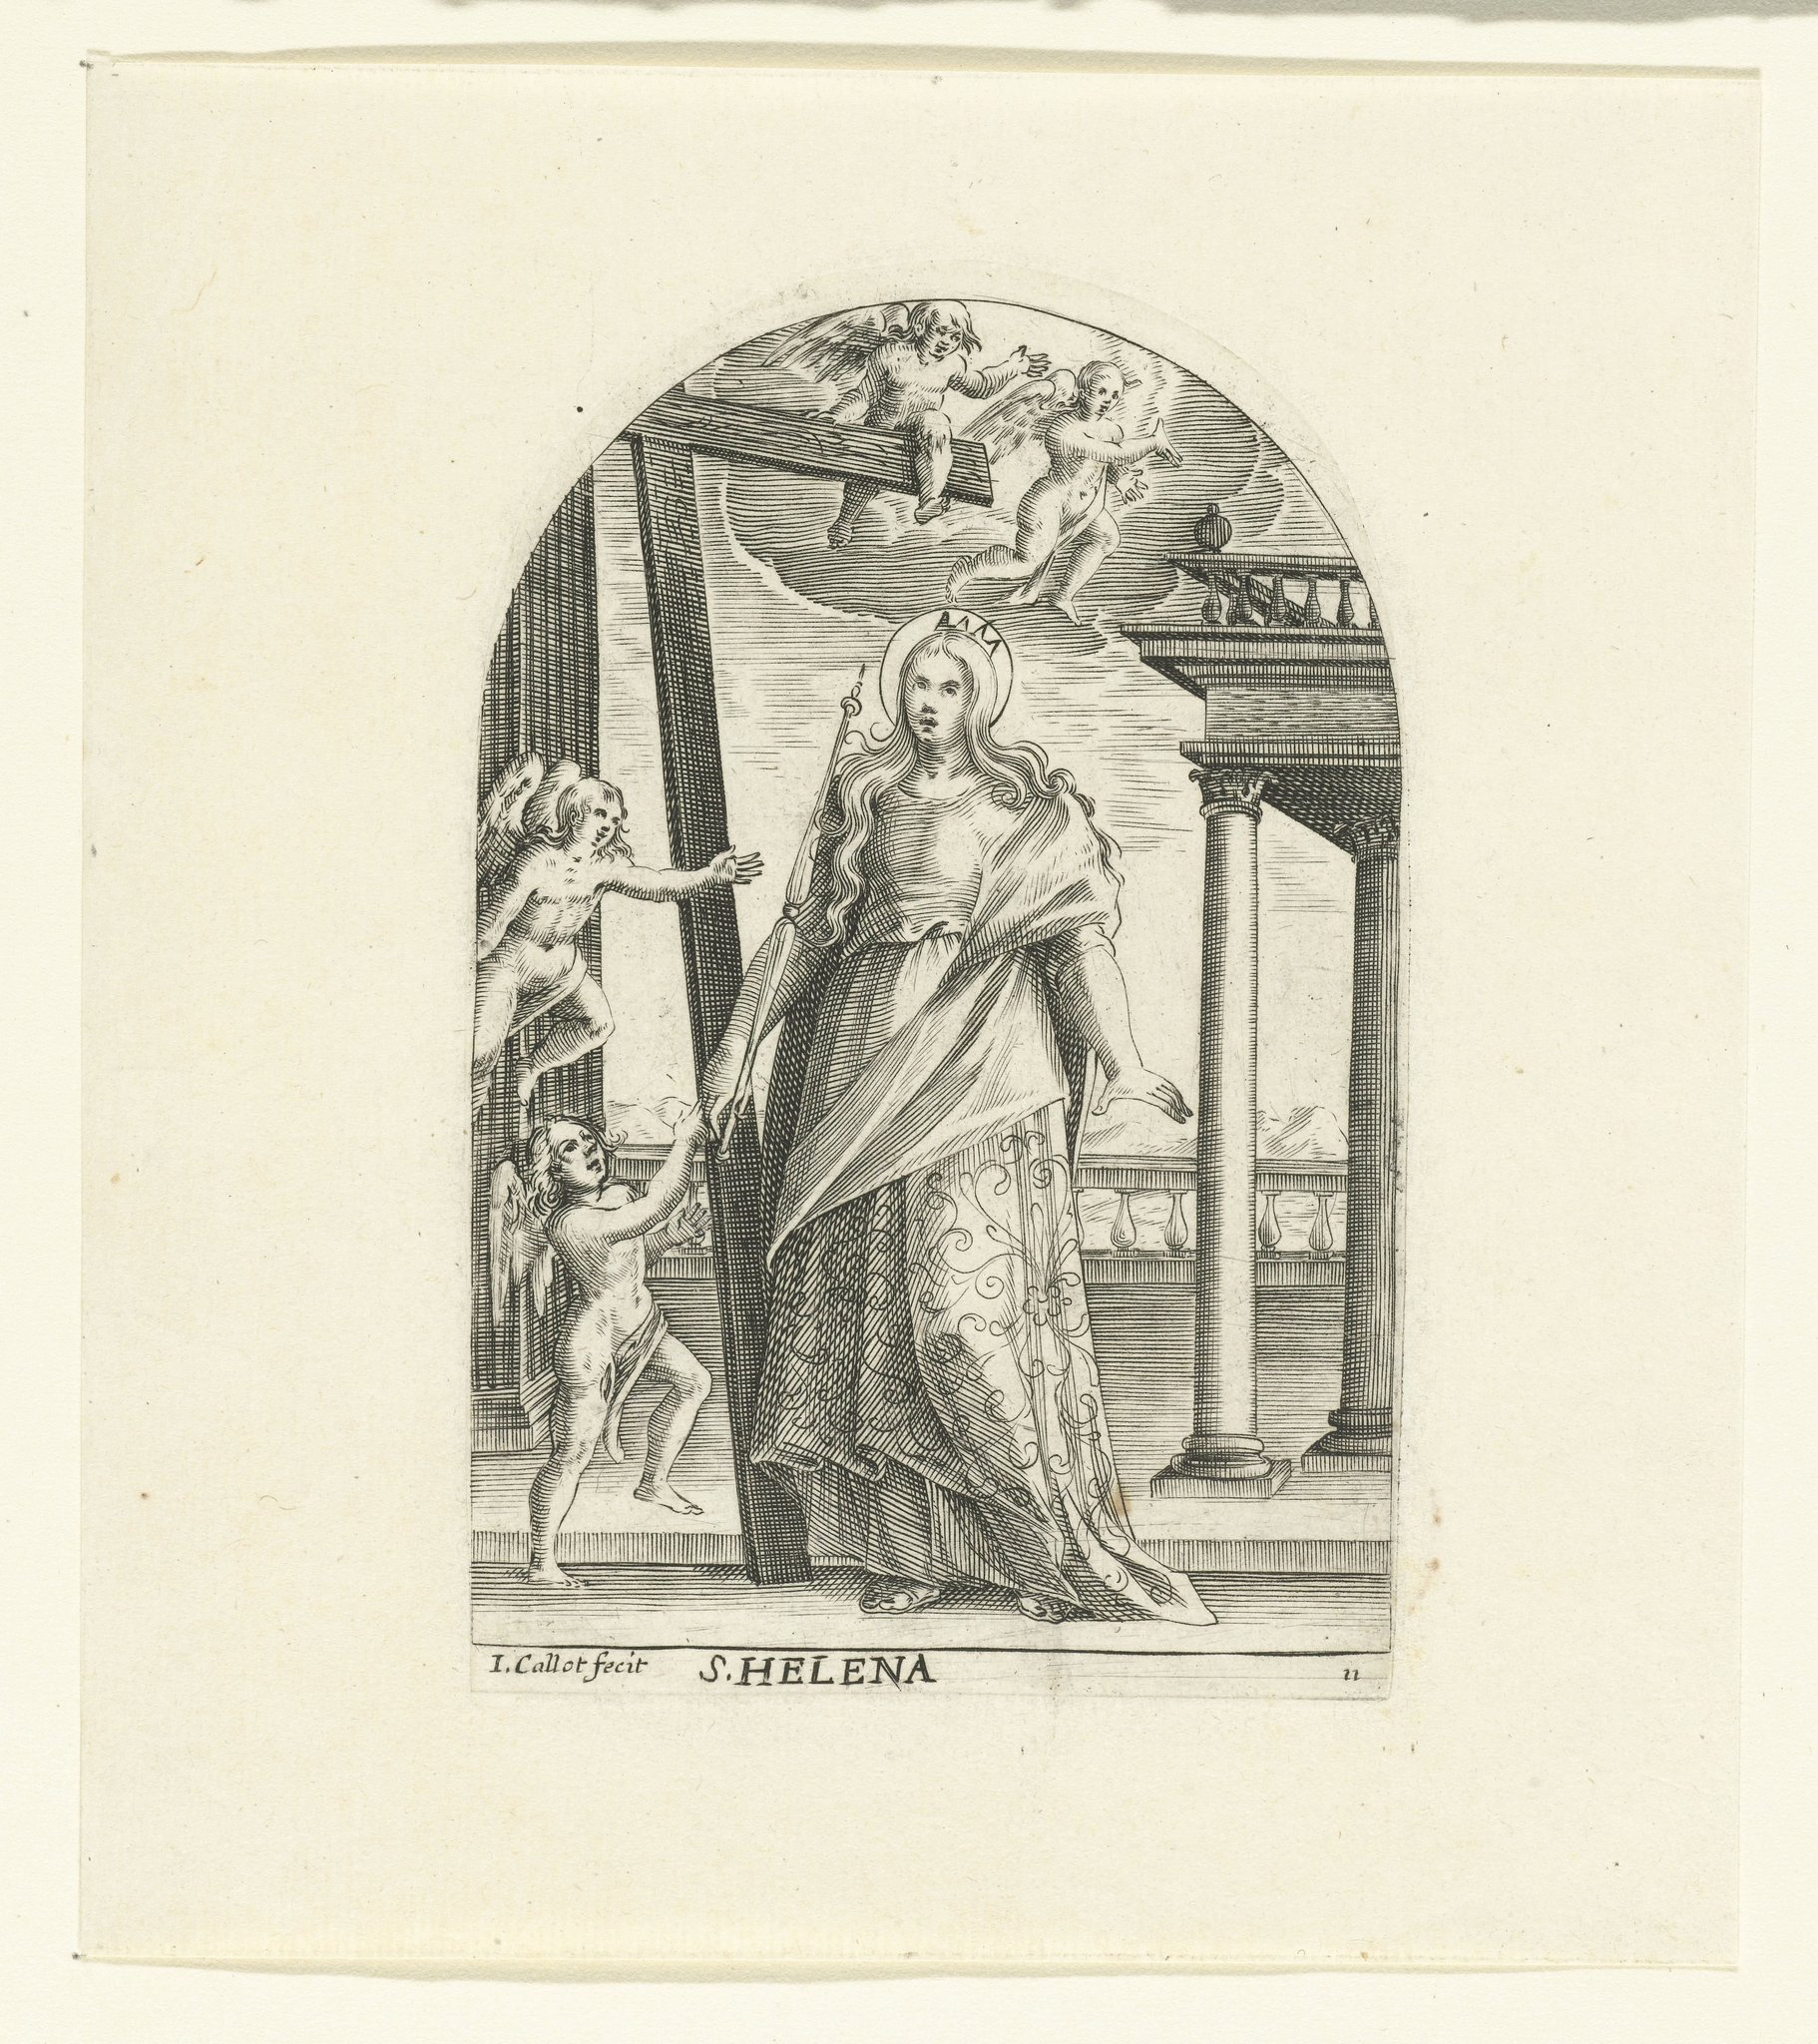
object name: print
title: S. Helena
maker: jacques callot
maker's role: draughtsman, print maker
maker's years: 1592-1635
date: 1608-1611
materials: paper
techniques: engraving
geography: rome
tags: empress helena, mother of constantine the great; possible attributes: model of church, (royal) crown, crown of thorns, cross, three nails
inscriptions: collector's mark: Lugt 240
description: De Heilige Helena, staand naast een kruis, op een terras of bordes met klassieke architectuur. Om haar heen staan en vliegen engelen. Onder de voorstelling een onderschrift in Latijn. Deze prent is onderdeel van (de tweede staat van) een serie van 29 voorstellingen van schilderijen en sculpturen in kerken te Rome, genummerd 1-16 en 1-13. (De eerste staat van deze serie, waarin de prenten ongenummerd zijn, behelst ook een titelprent).